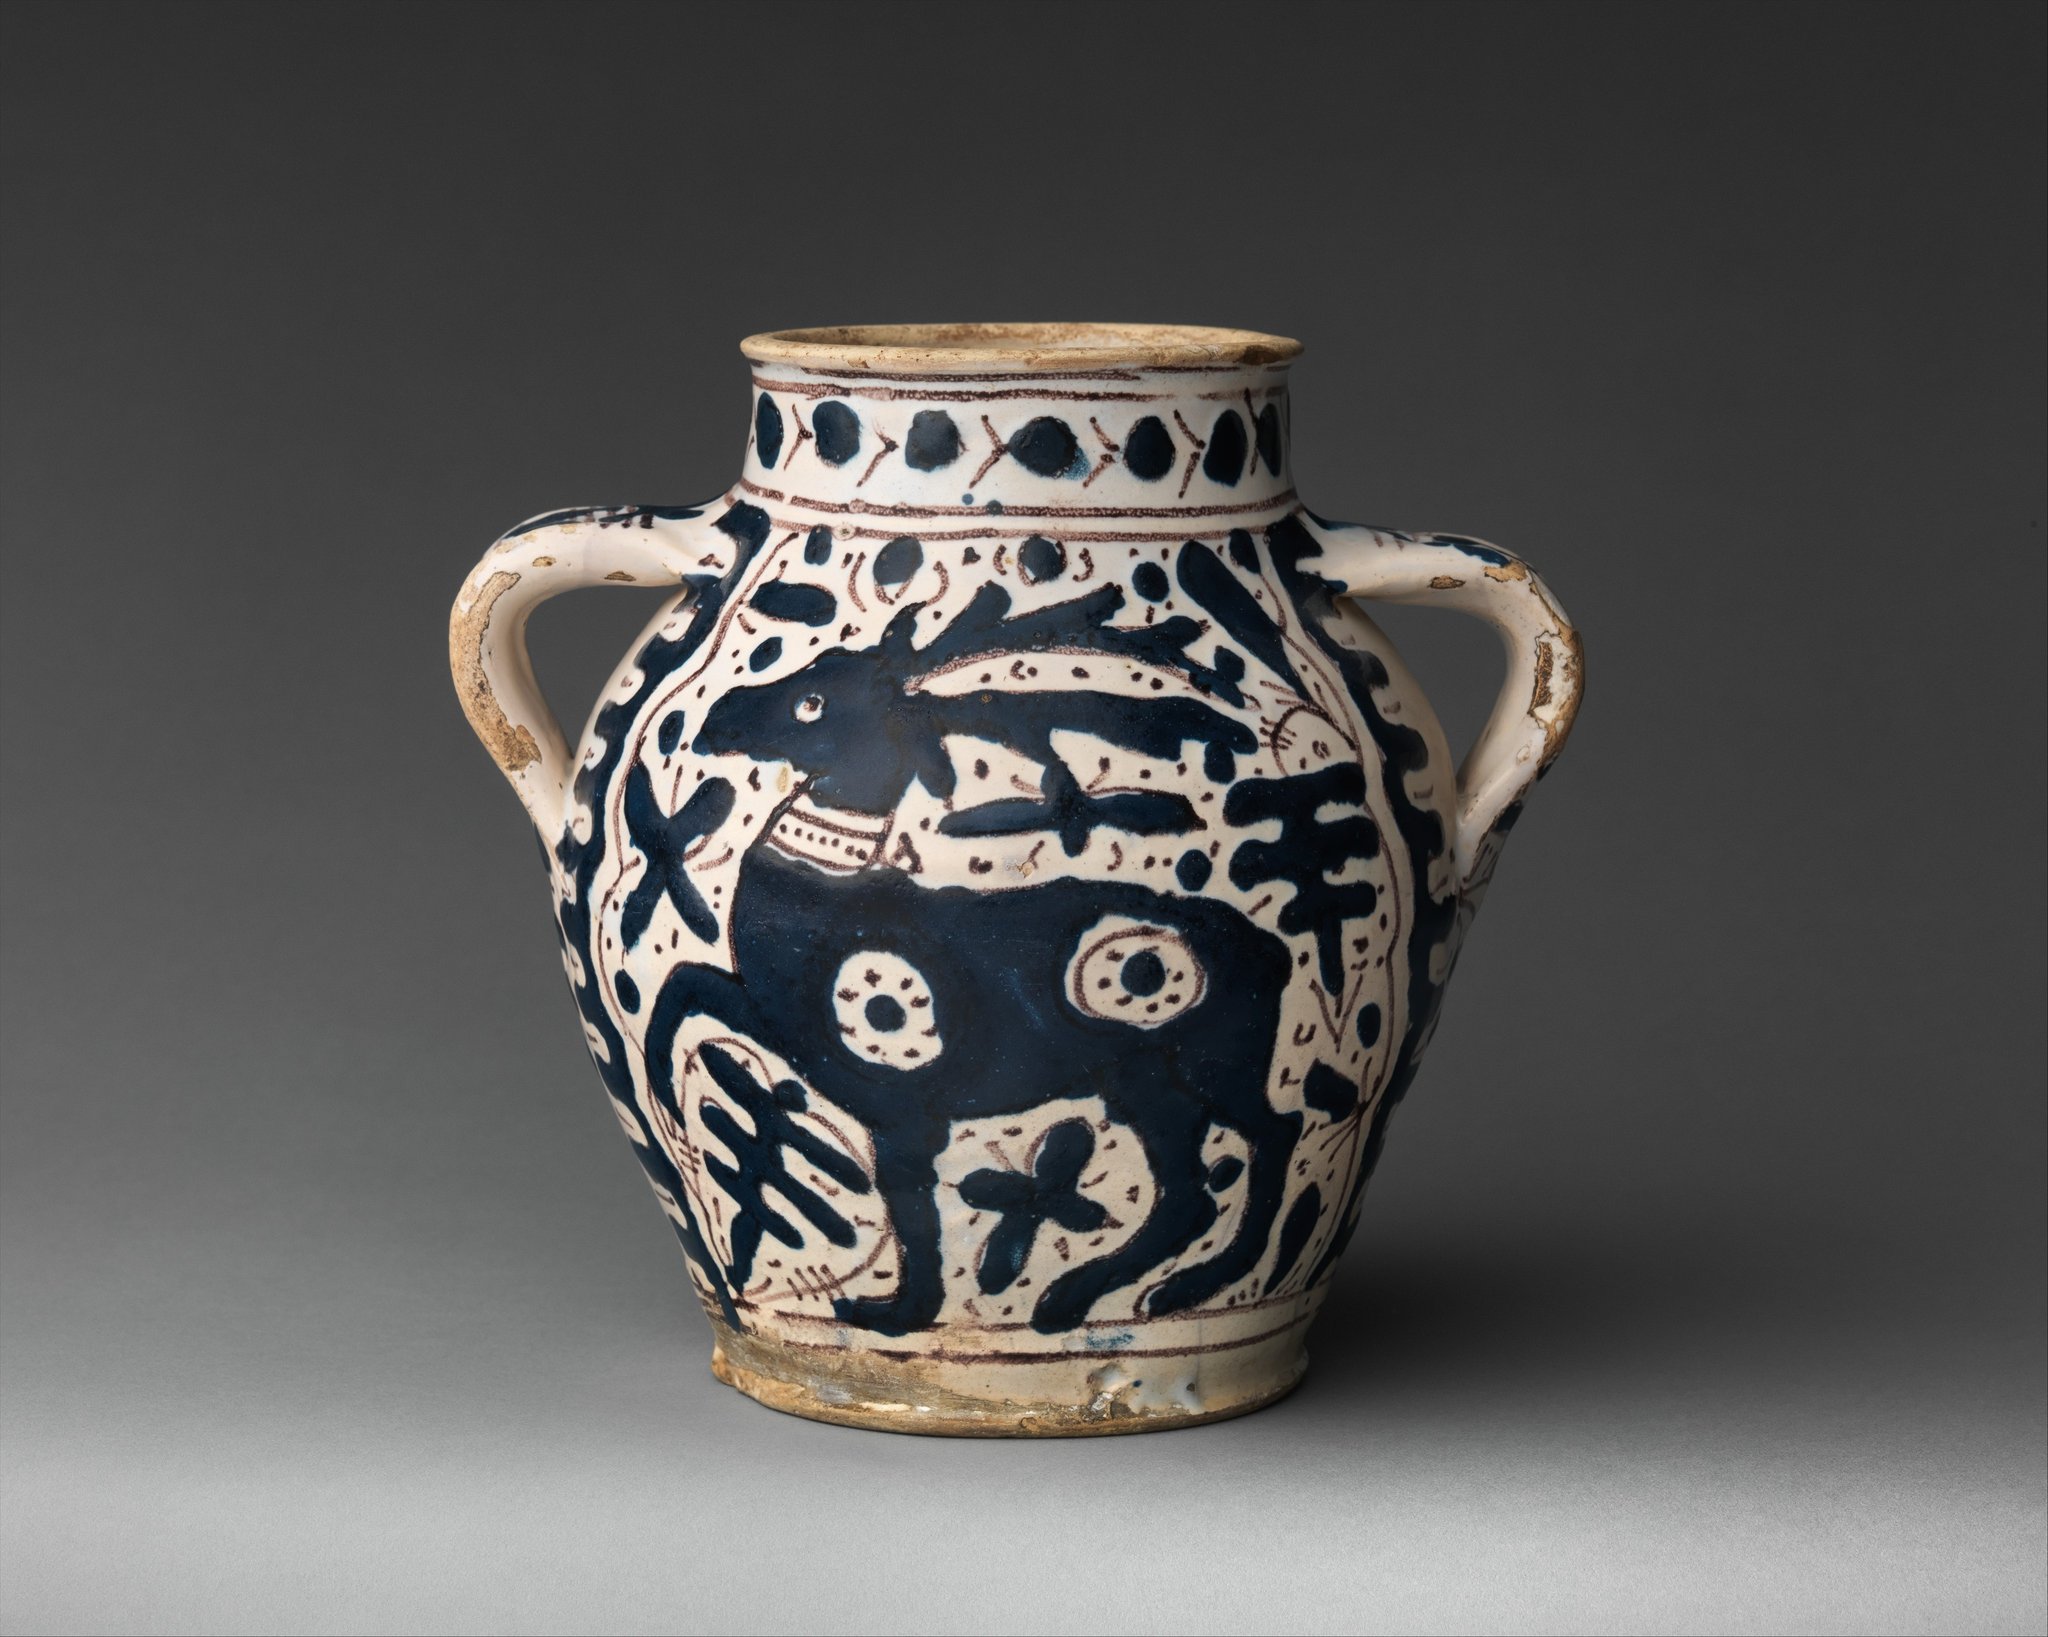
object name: jar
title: Two-Handled Jar with Stag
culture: italian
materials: earthenware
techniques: glazing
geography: italy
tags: deer